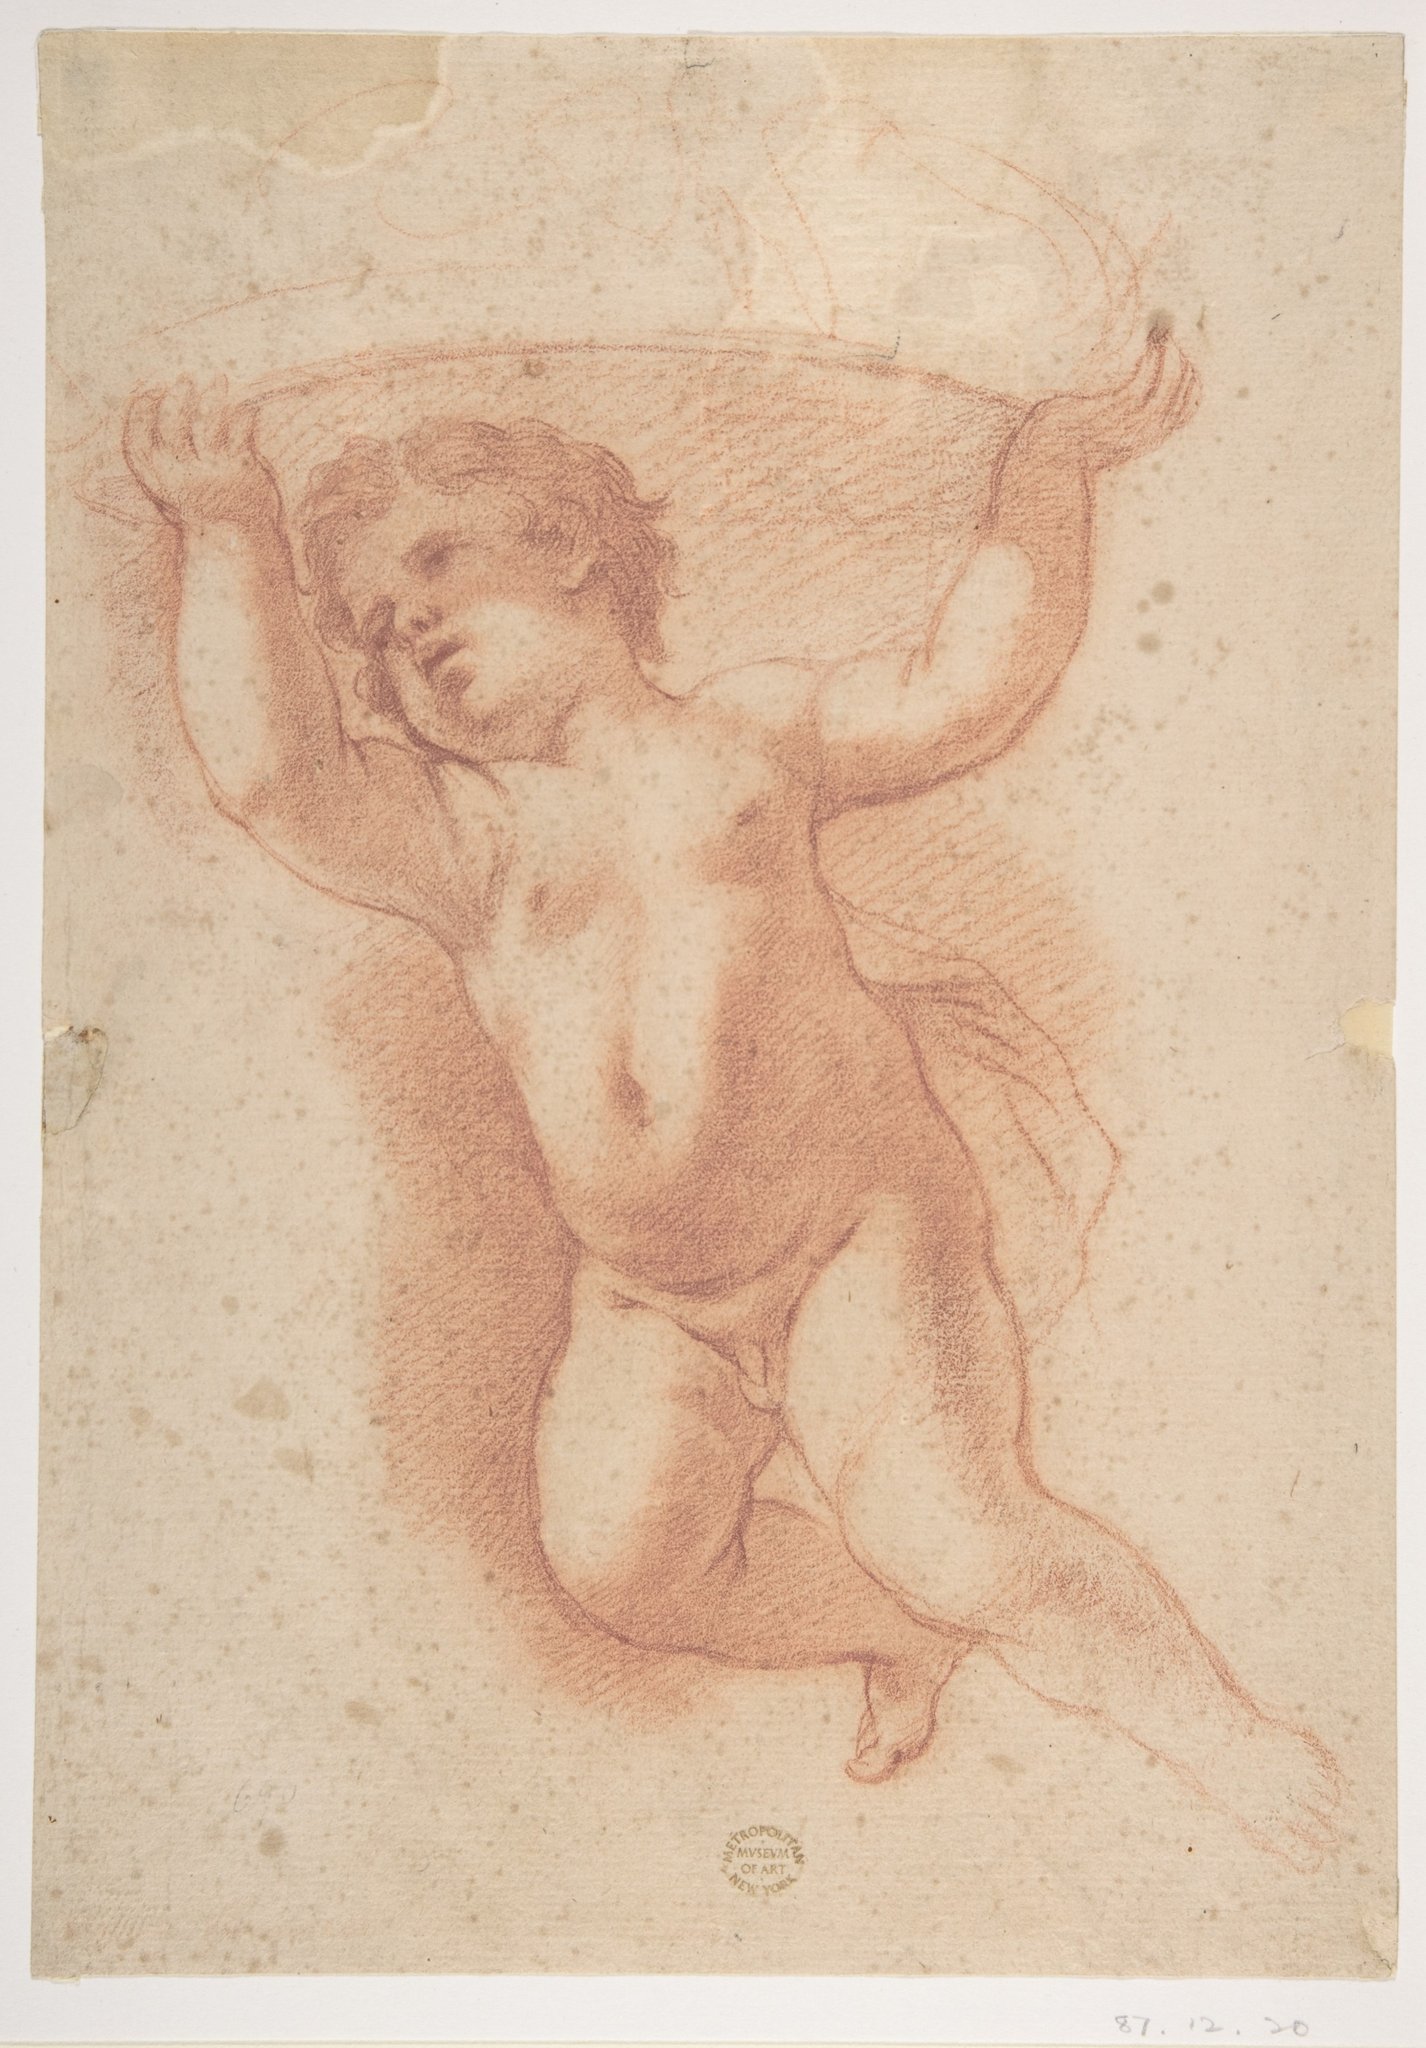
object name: drawing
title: Flying Putto Supporting a Crown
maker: anton domenico gabbiani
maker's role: artist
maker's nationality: italian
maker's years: 1652-1726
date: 1652-1726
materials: chalk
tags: male nudes